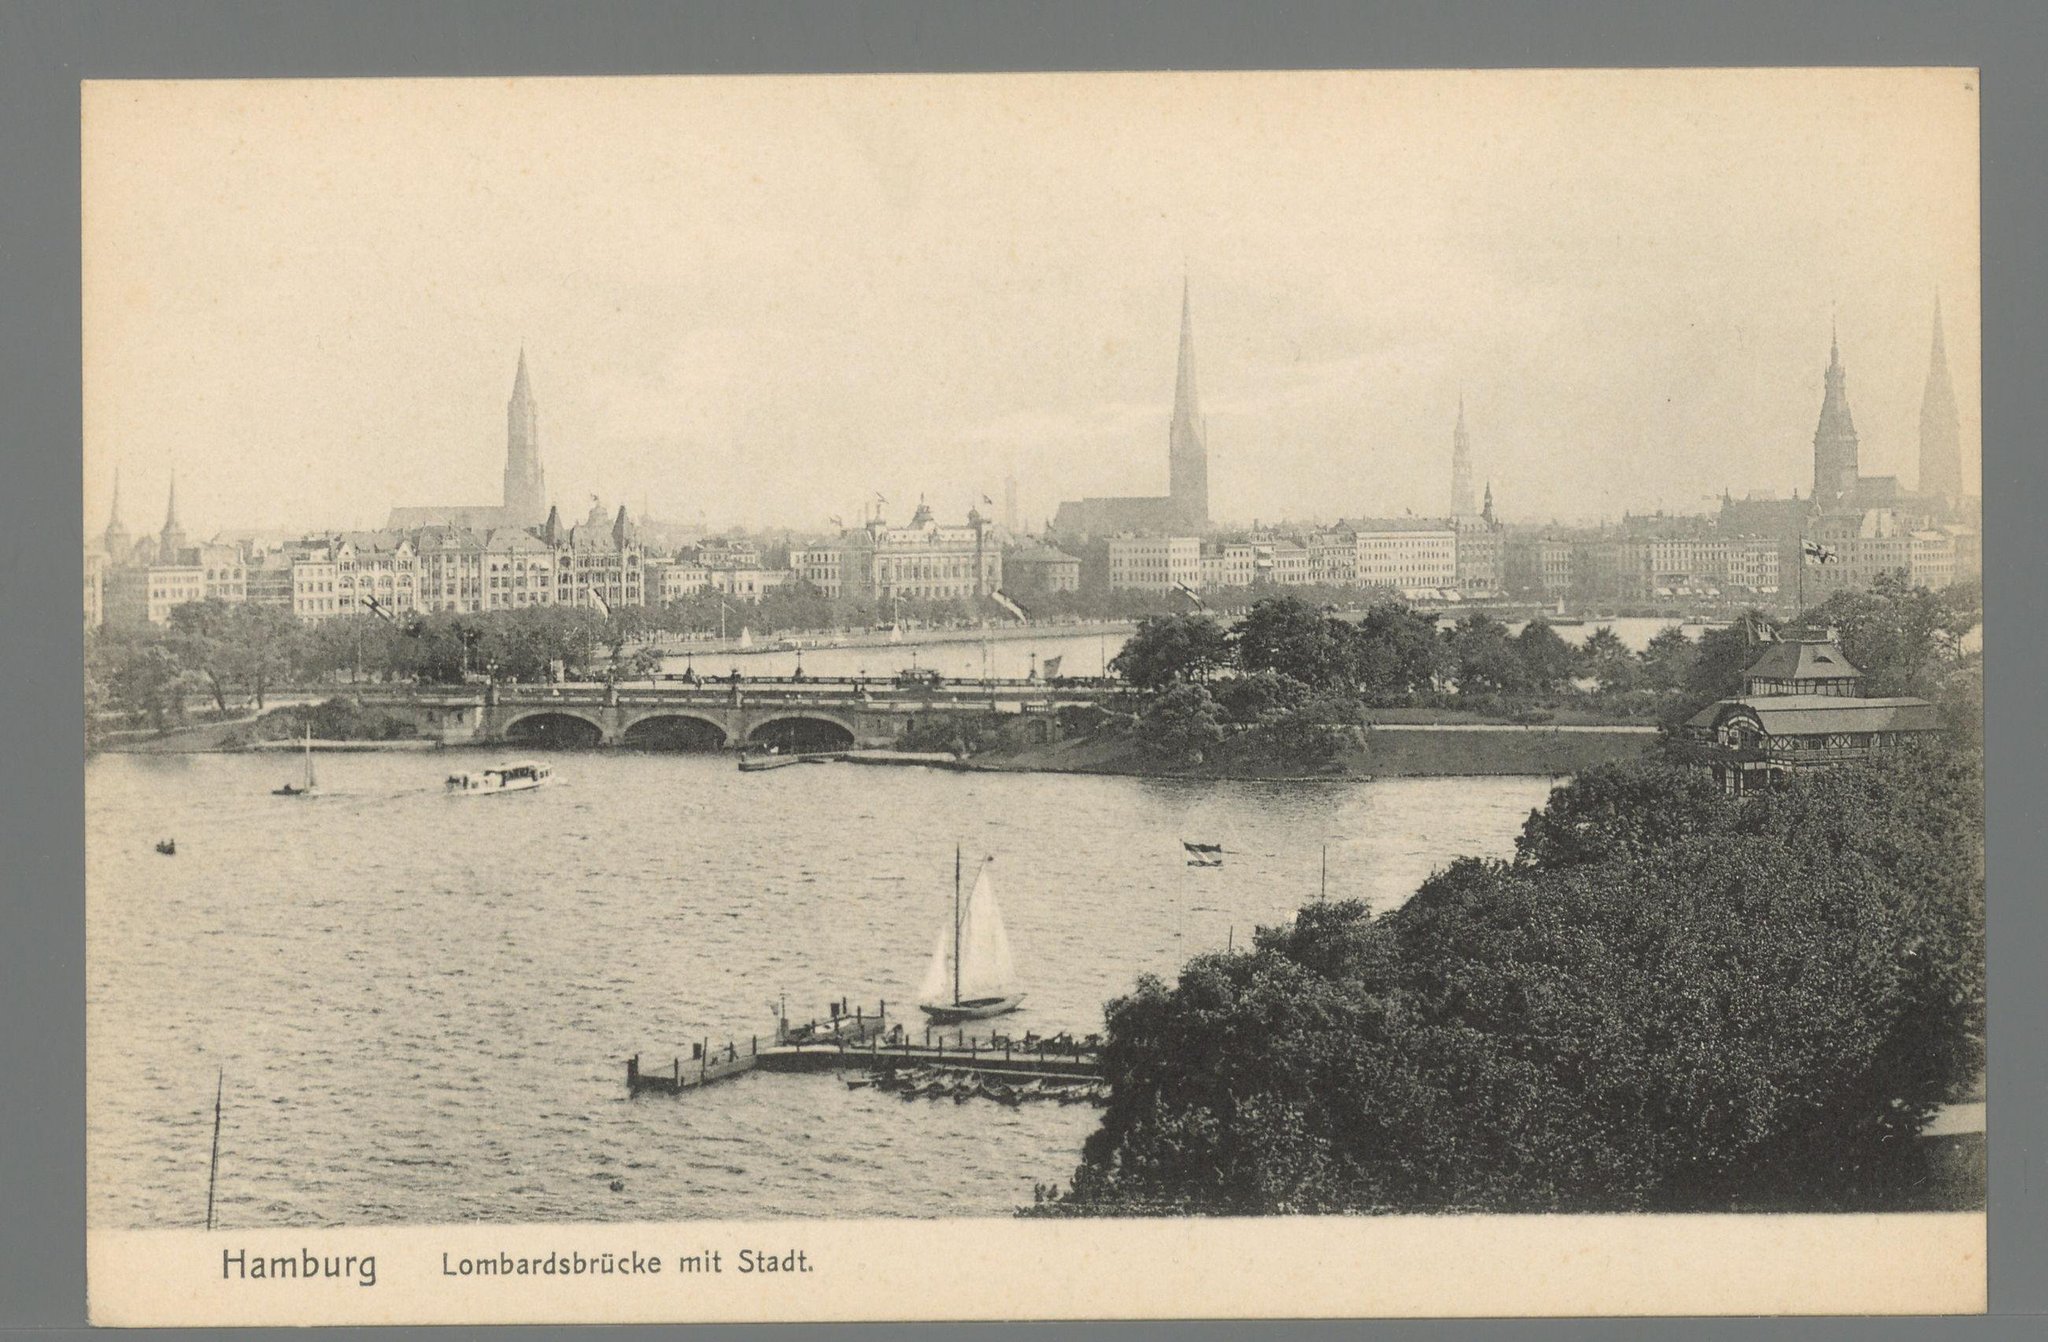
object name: ansichtkaart, prentbriefkaart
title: Hamburg. Lombardsbrücke mit Stadt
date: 1906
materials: cardboard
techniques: photograph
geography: hamburg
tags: city-view, and landscape with man-made constructions, canals, waters (in city), bridge in city across river, canal, etc.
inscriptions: date